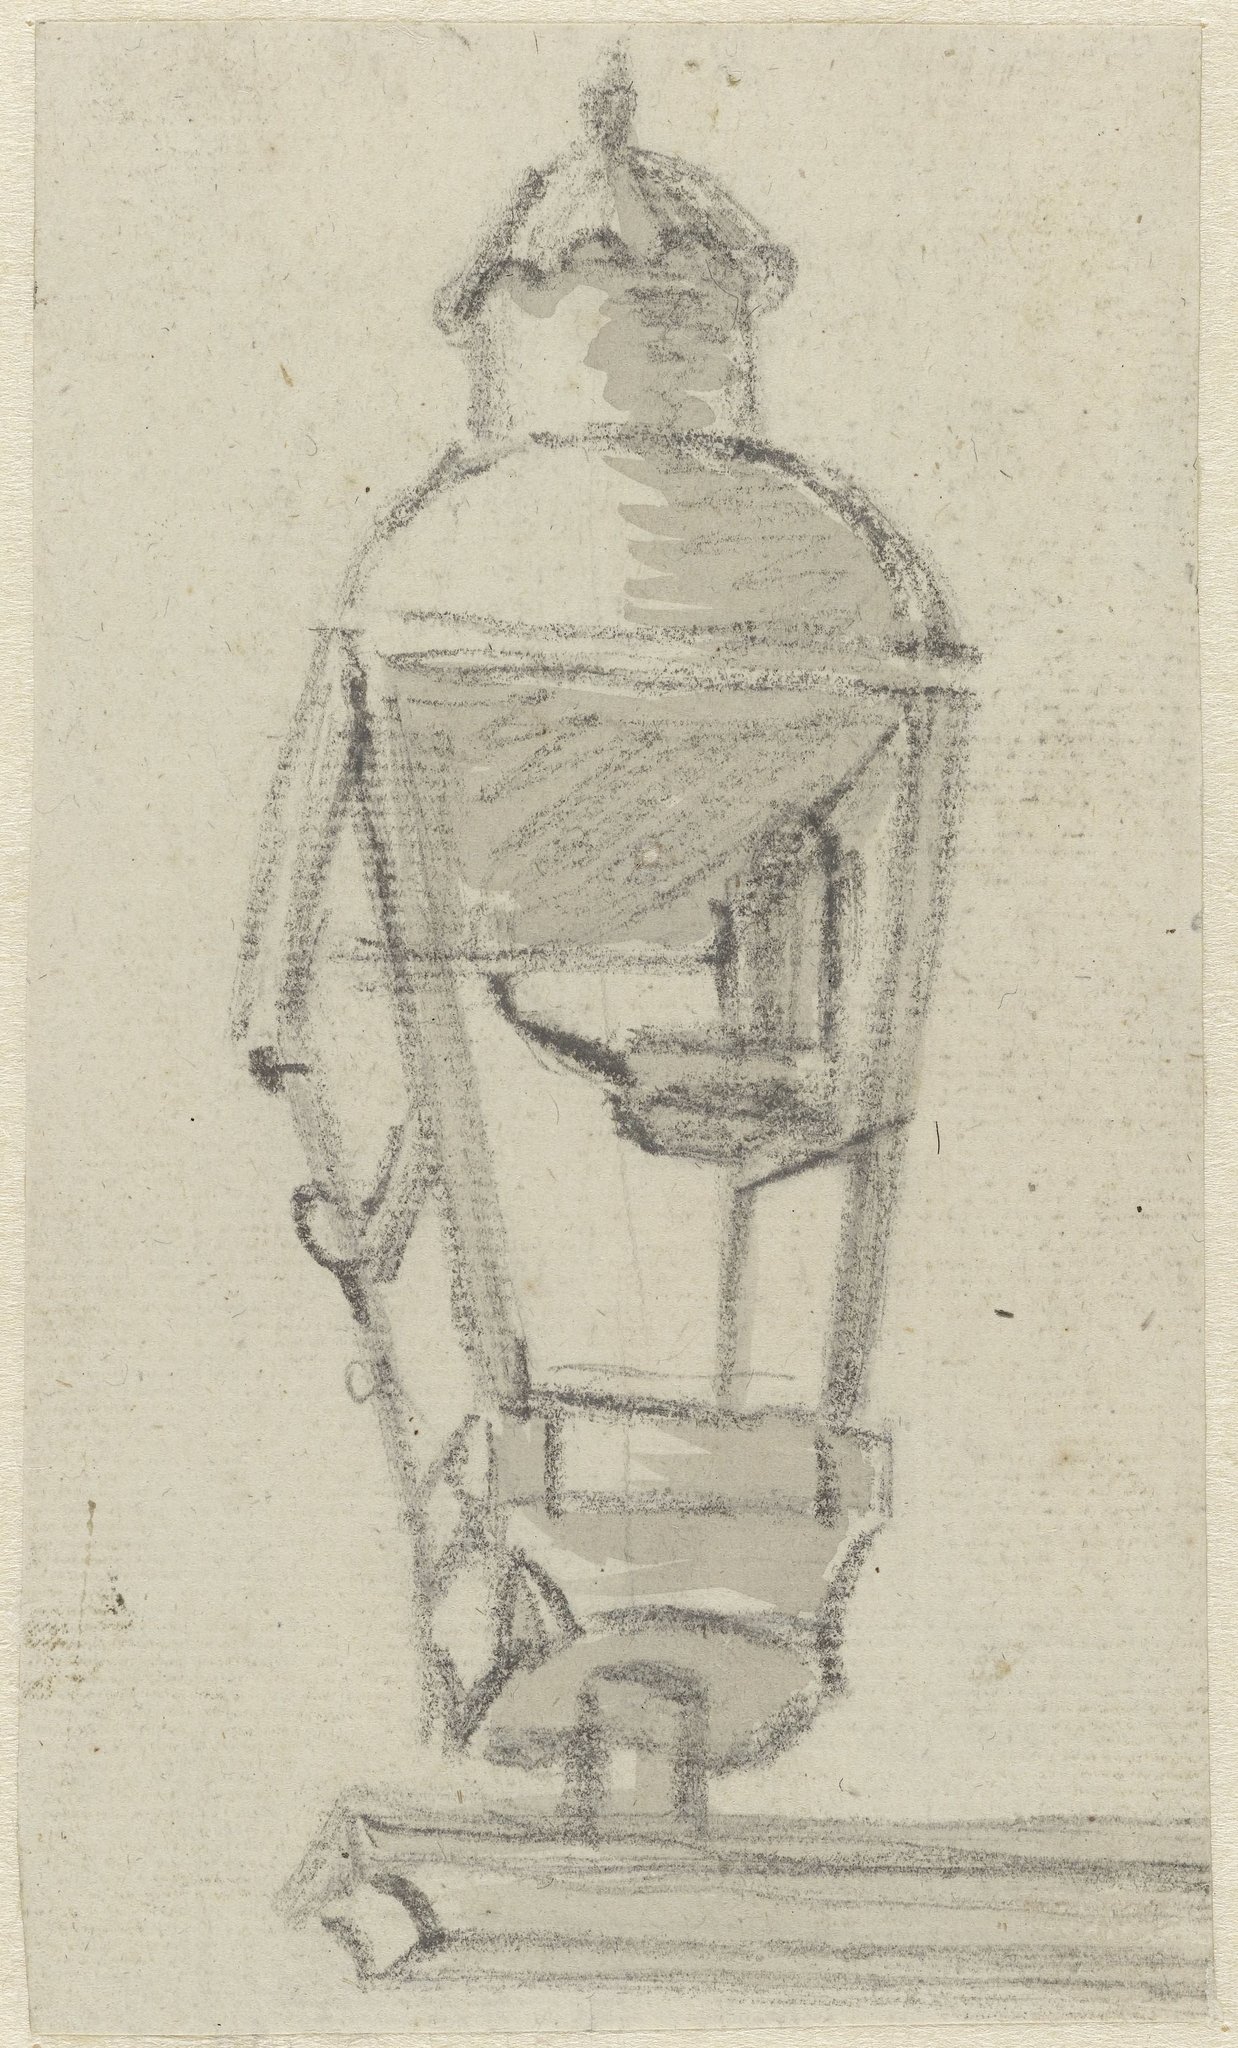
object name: design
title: Straatlantaarn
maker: jan van der heyden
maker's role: draughtsman, painter, print maker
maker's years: 1637-1712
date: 1674-1679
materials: chalk, paper, pencil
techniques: brush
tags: street lighting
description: Tekening voor het manuscript 't Licht der Lamp-Lantaarens (?)